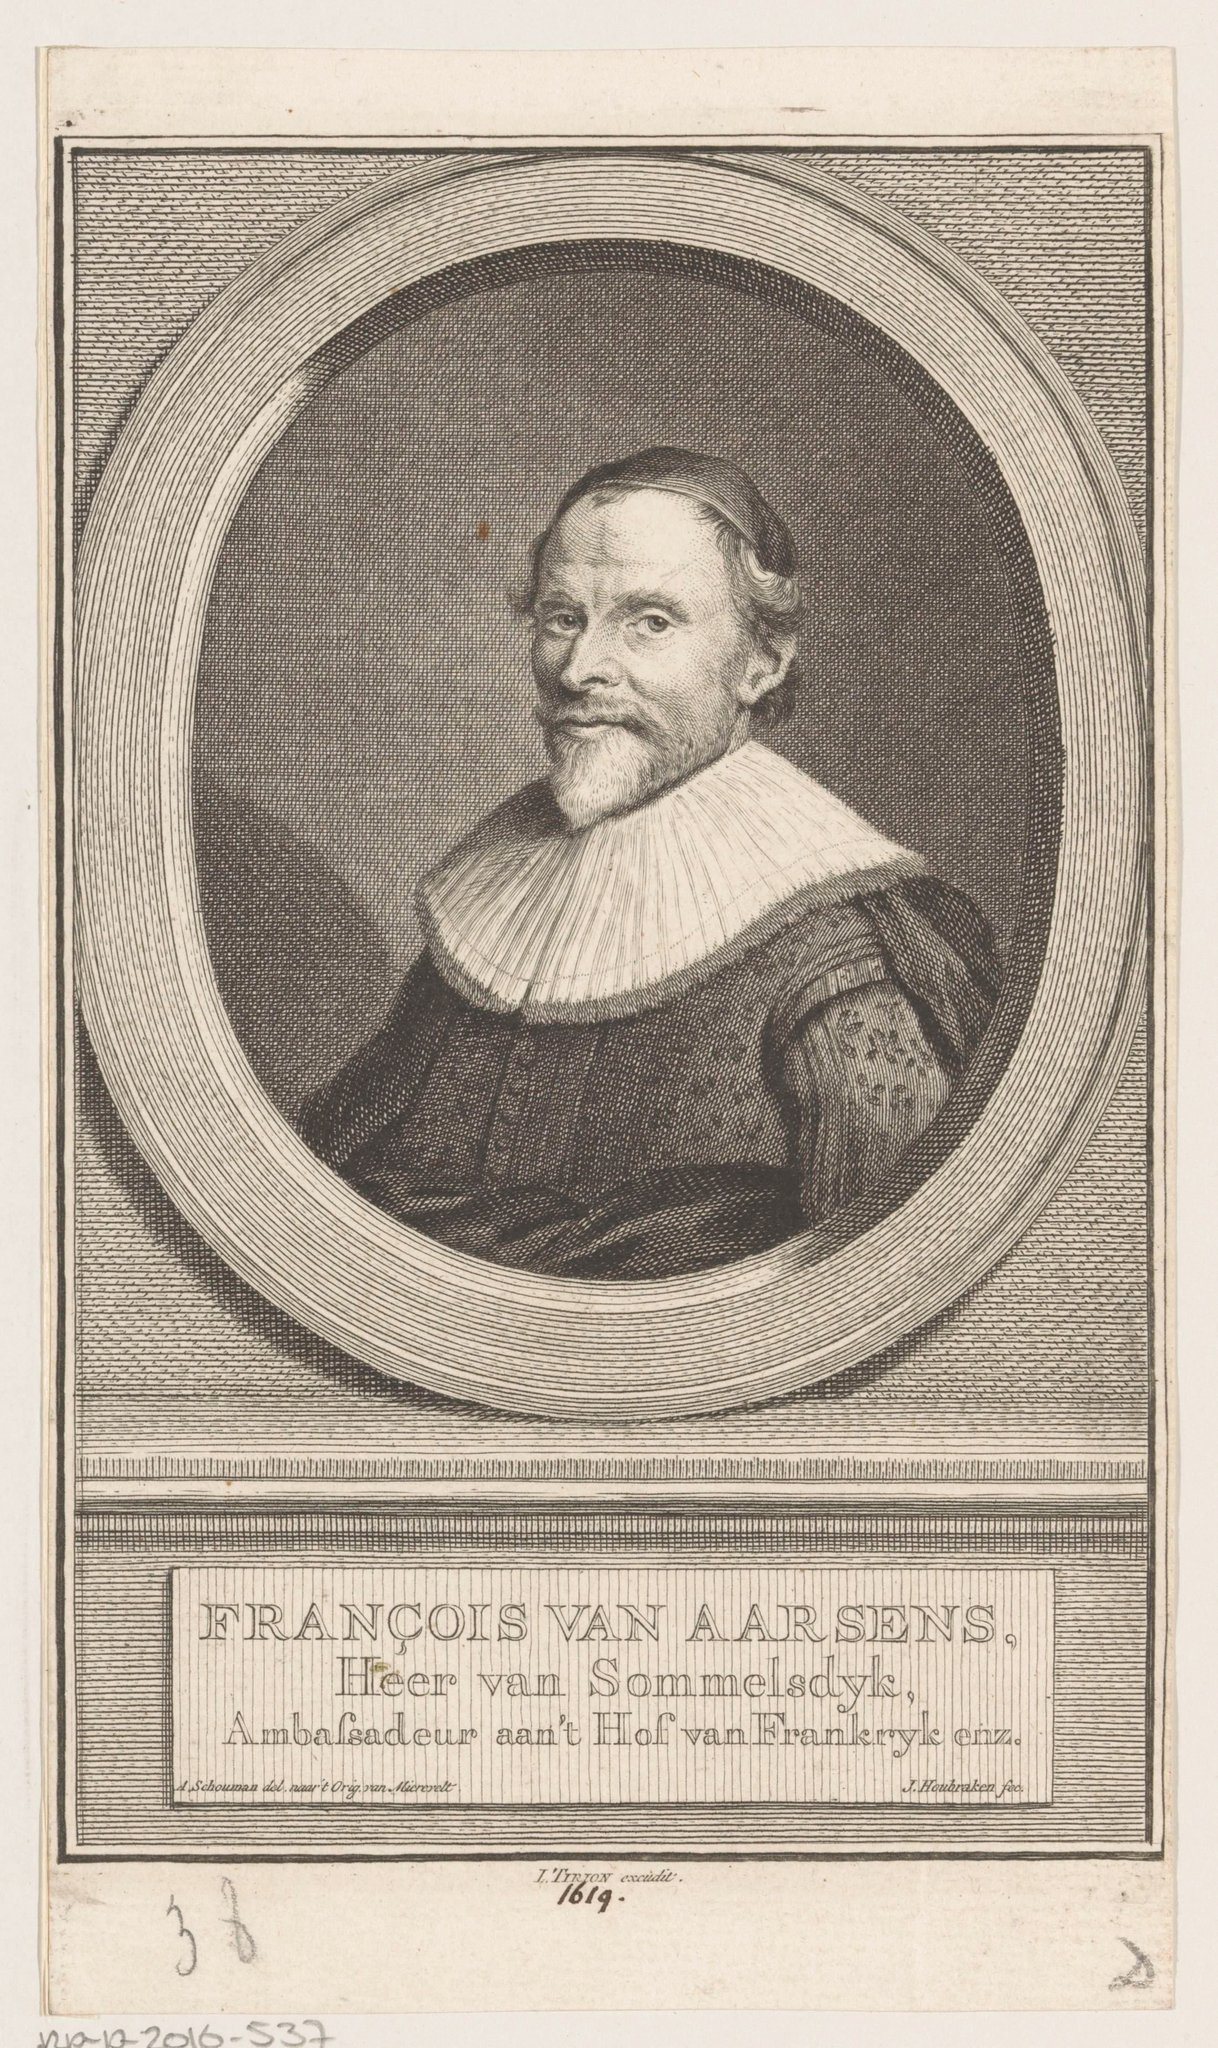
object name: print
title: Portret van François van Aerssen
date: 1727-1765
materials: paper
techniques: engraving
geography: amsterdam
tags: brussels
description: Portret van François van Aerssen in een ovale omlijsting. In een kader zijn naam en titels.